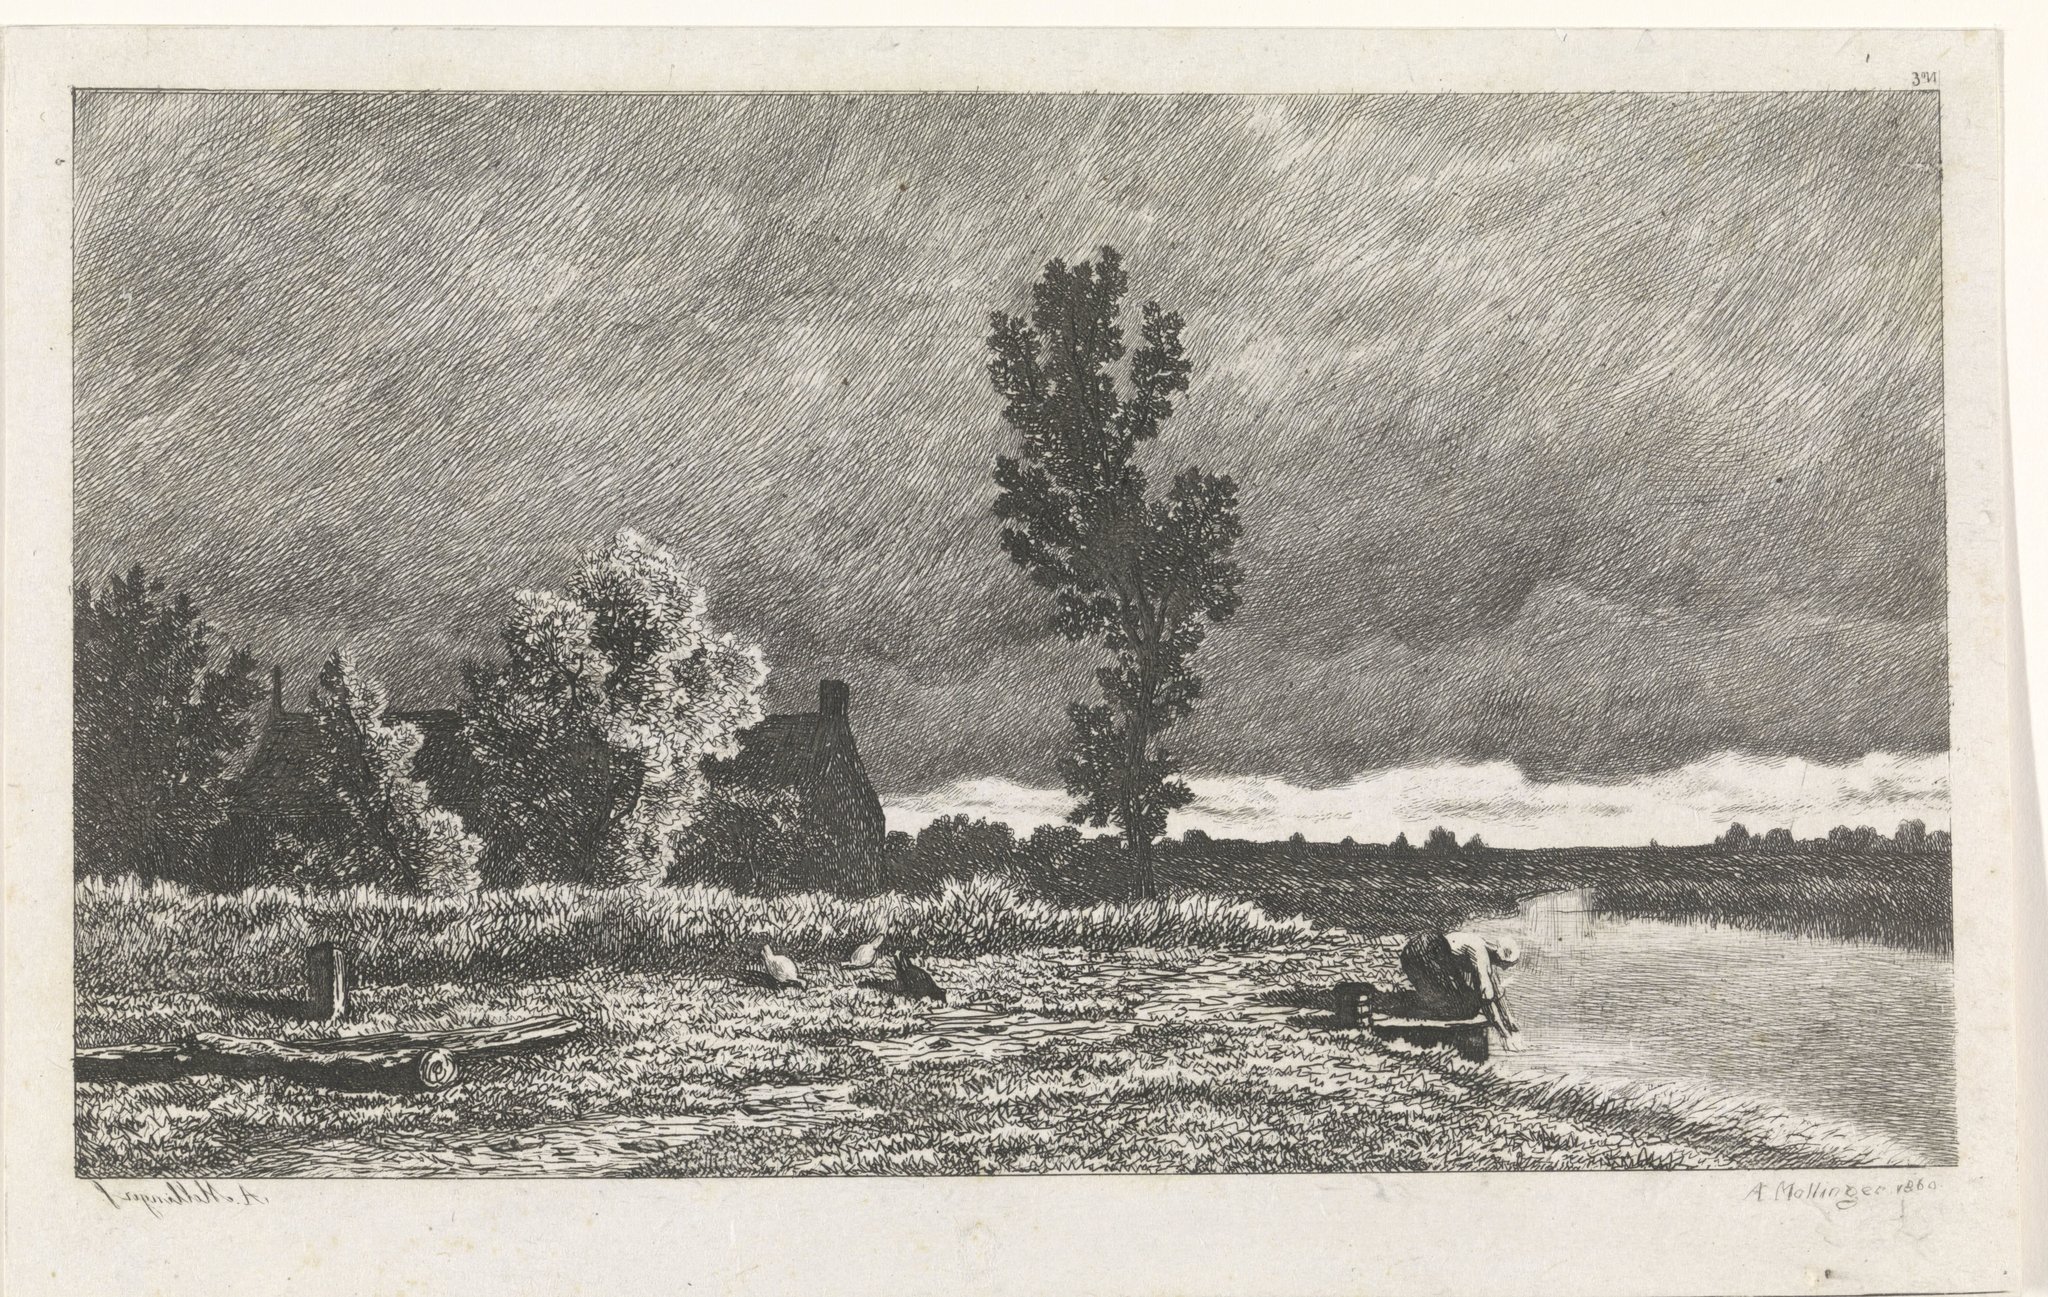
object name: print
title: Landschap met een vrouw die de was doet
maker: alexander mollinger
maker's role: painter, print maker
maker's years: 1836-1867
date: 1860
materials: paper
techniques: etching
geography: netherlands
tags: clouds, laundering, farm or solitary house in landscape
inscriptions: collector's mark: Lugt 2228, collector's mark: Lugt 2760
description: Op een steiger aan het water doet een vrouw de was. In het weiland kippen, links een woning. Aan de hemel donkere wolken. Rechtsboven genummerd: 3.